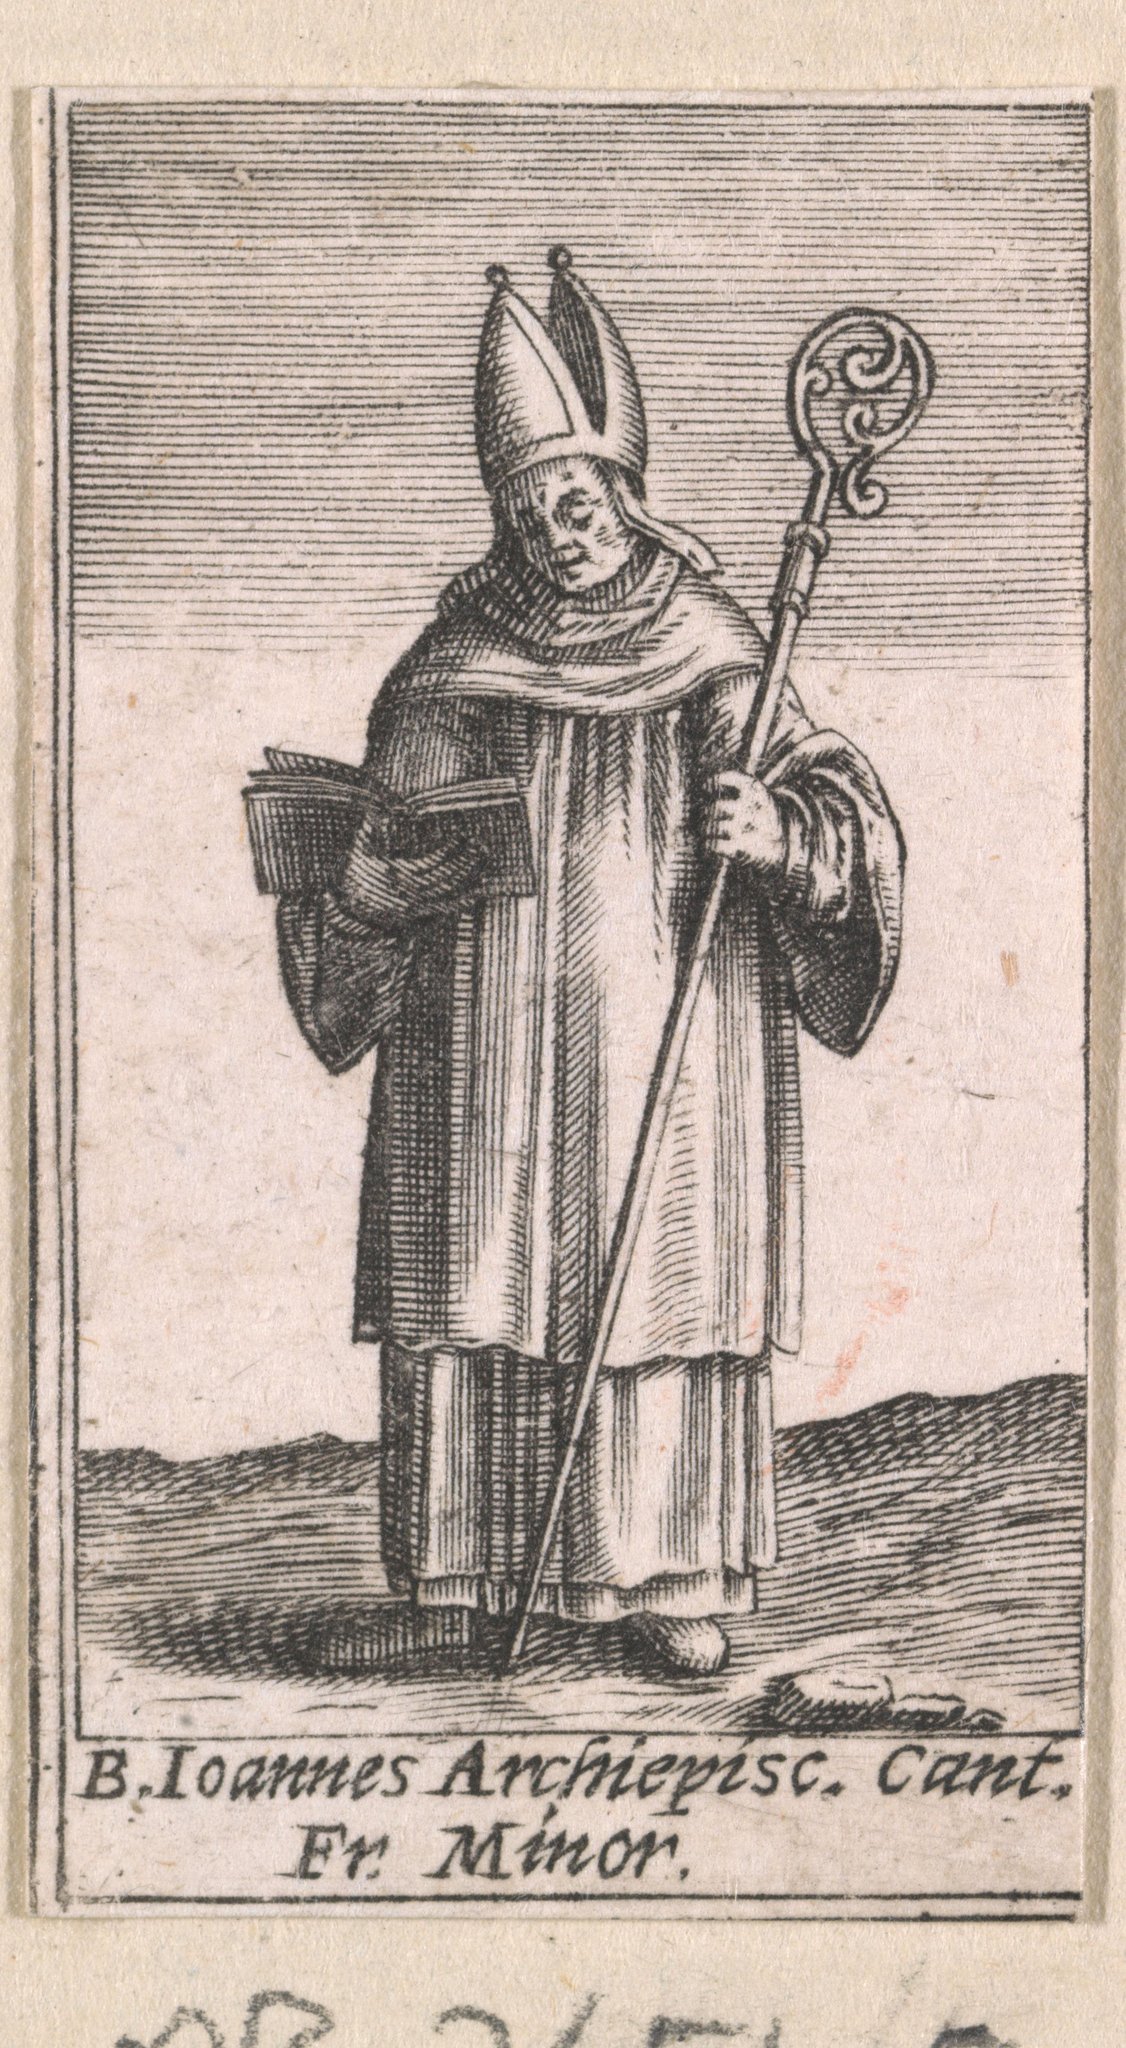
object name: print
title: Portret van de Heilige Bonaventura, aartsbisschop van Lyon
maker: Anonymous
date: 1570-1632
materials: paper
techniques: engraving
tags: archbishop, bishop, etc. (roman catholic), insignia of bishop, e.g. mitre, crozier, bonaventura, cardinal bishop of albano and minister general of the franciscan order; possible attributes: book, cardinal's hat (sometimes hanging from a tree), crucifix (sometimes flowering)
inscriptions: collector's mark: Lugt 240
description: Deze prent vormt samen met RP-P-OB-7651-2 t/m RP-P-OB-7651-11 een lijst rondom RP-P-OB-7609.